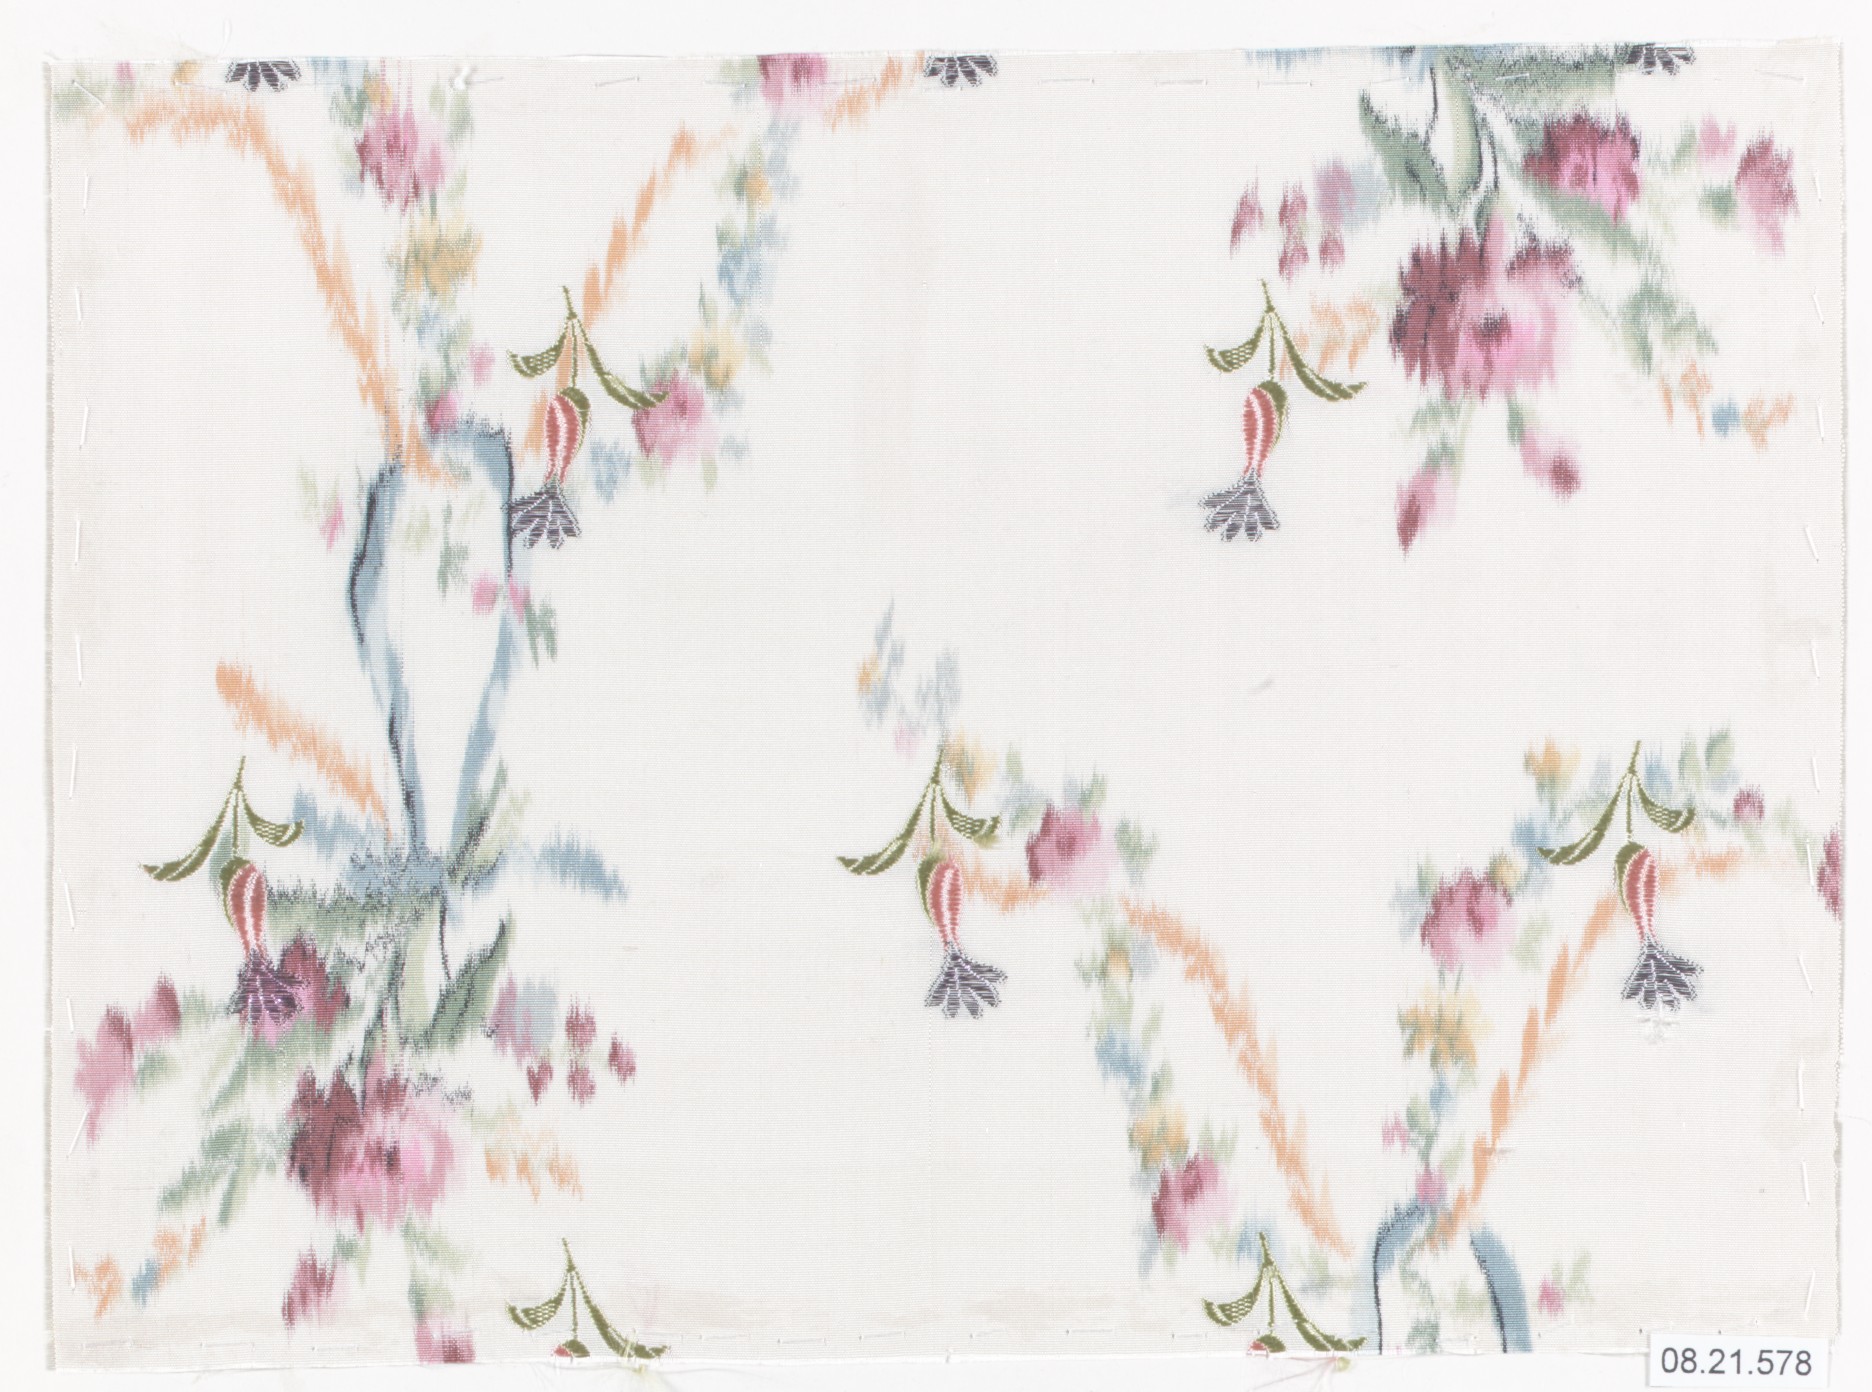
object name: textile sample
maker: Anonymous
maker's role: designer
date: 1900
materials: silk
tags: flowers